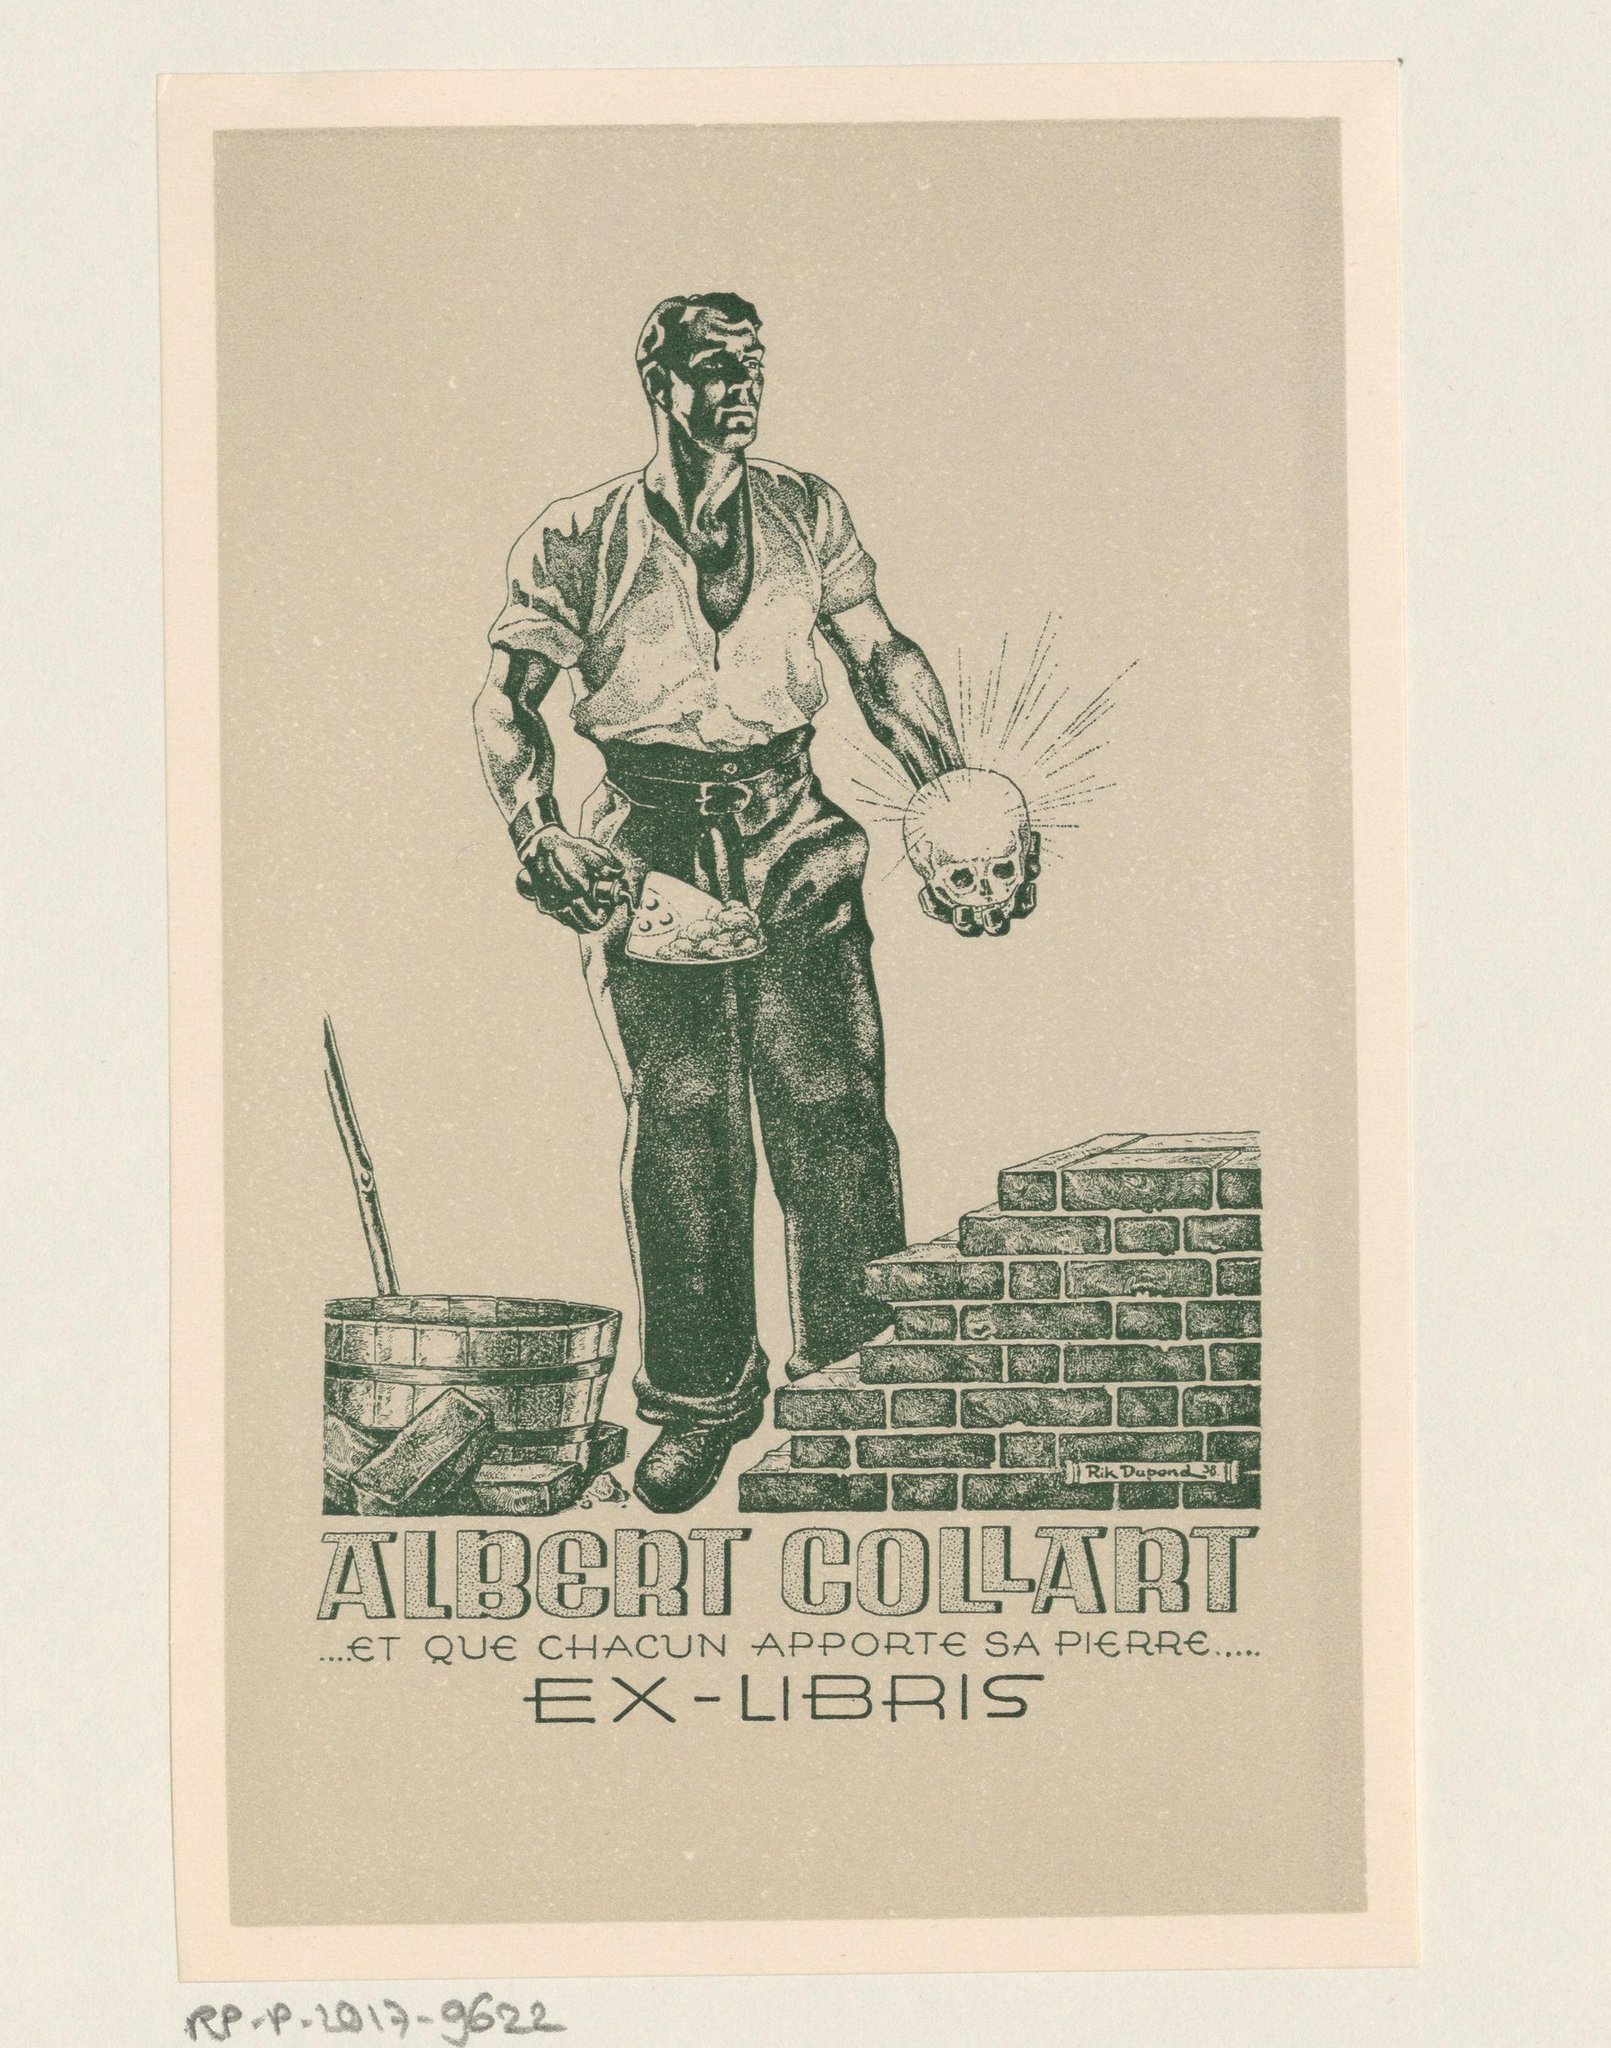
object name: bookplate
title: Ex libris van Albert Collart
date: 1938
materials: paper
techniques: planographic printing, printing block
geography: belgium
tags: standing figure, (human) skull, mason at work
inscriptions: date